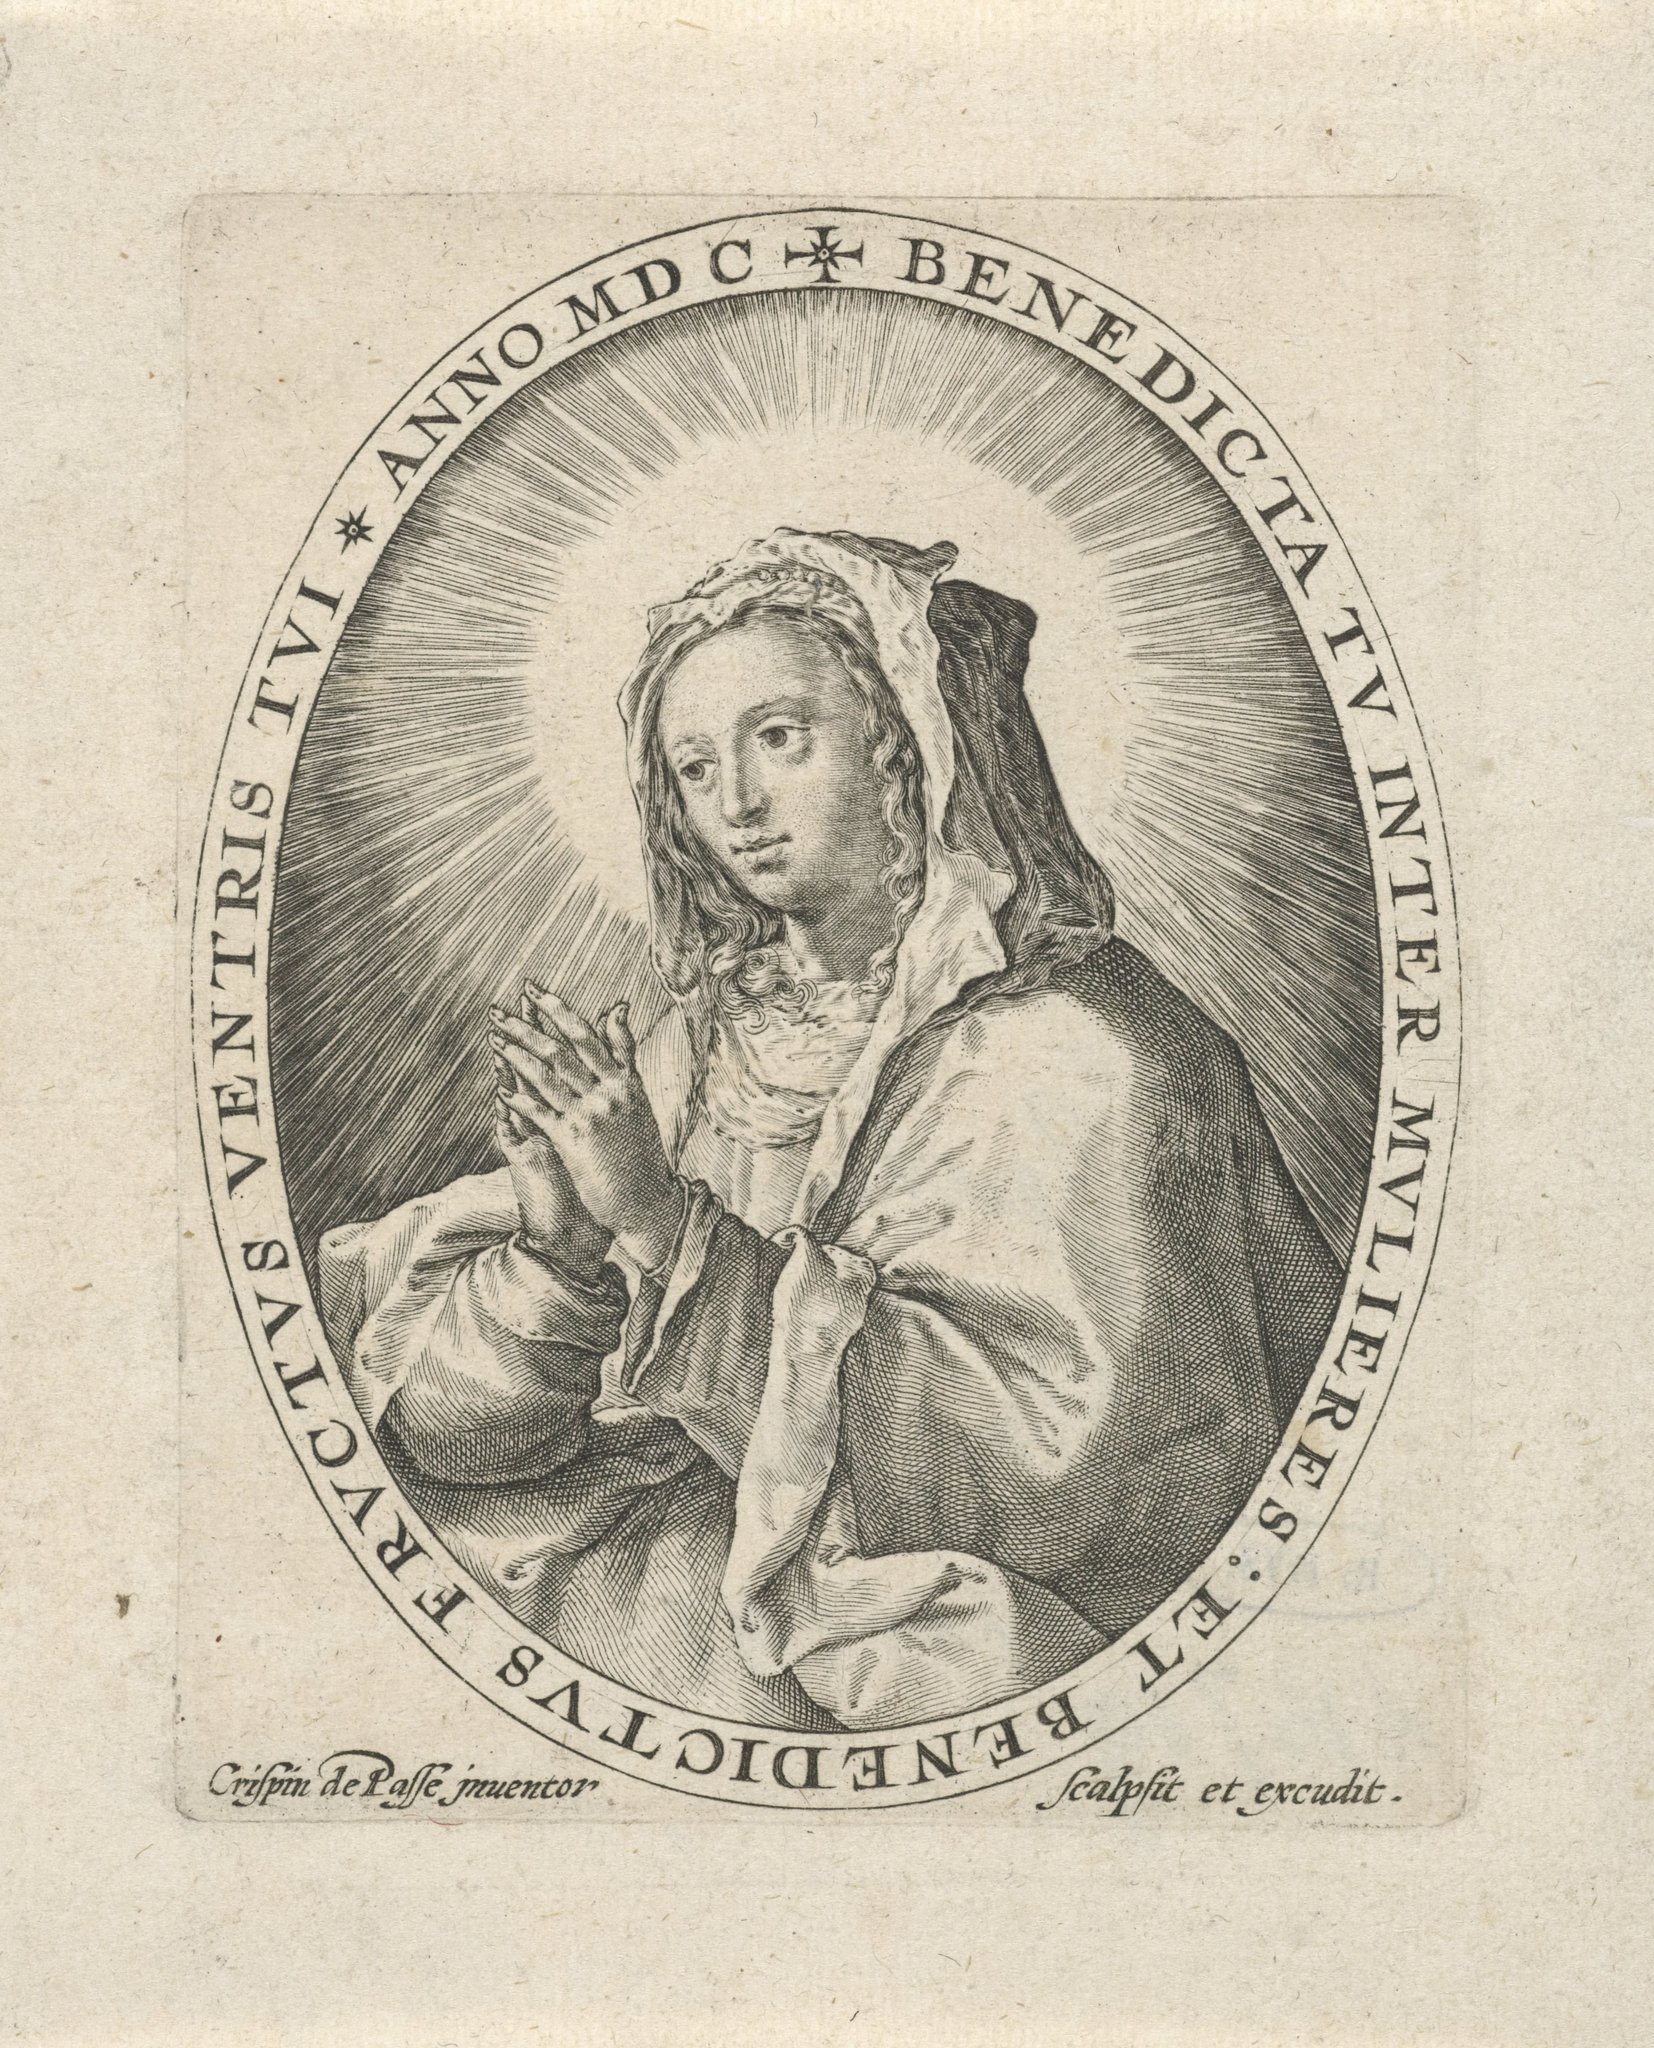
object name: print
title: Maria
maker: crispijn van de passe (i)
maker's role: draughtsman, print maker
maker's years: 1564-1637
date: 1600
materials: paper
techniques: engraving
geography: cologne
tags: mary praying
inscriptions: collector's mark: Lugt 2228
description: Maria, in gebed. De voorstelling is gevat in een ovale omlijsting met een randschrift in het Latijn. Pendant van een prent van Christus.